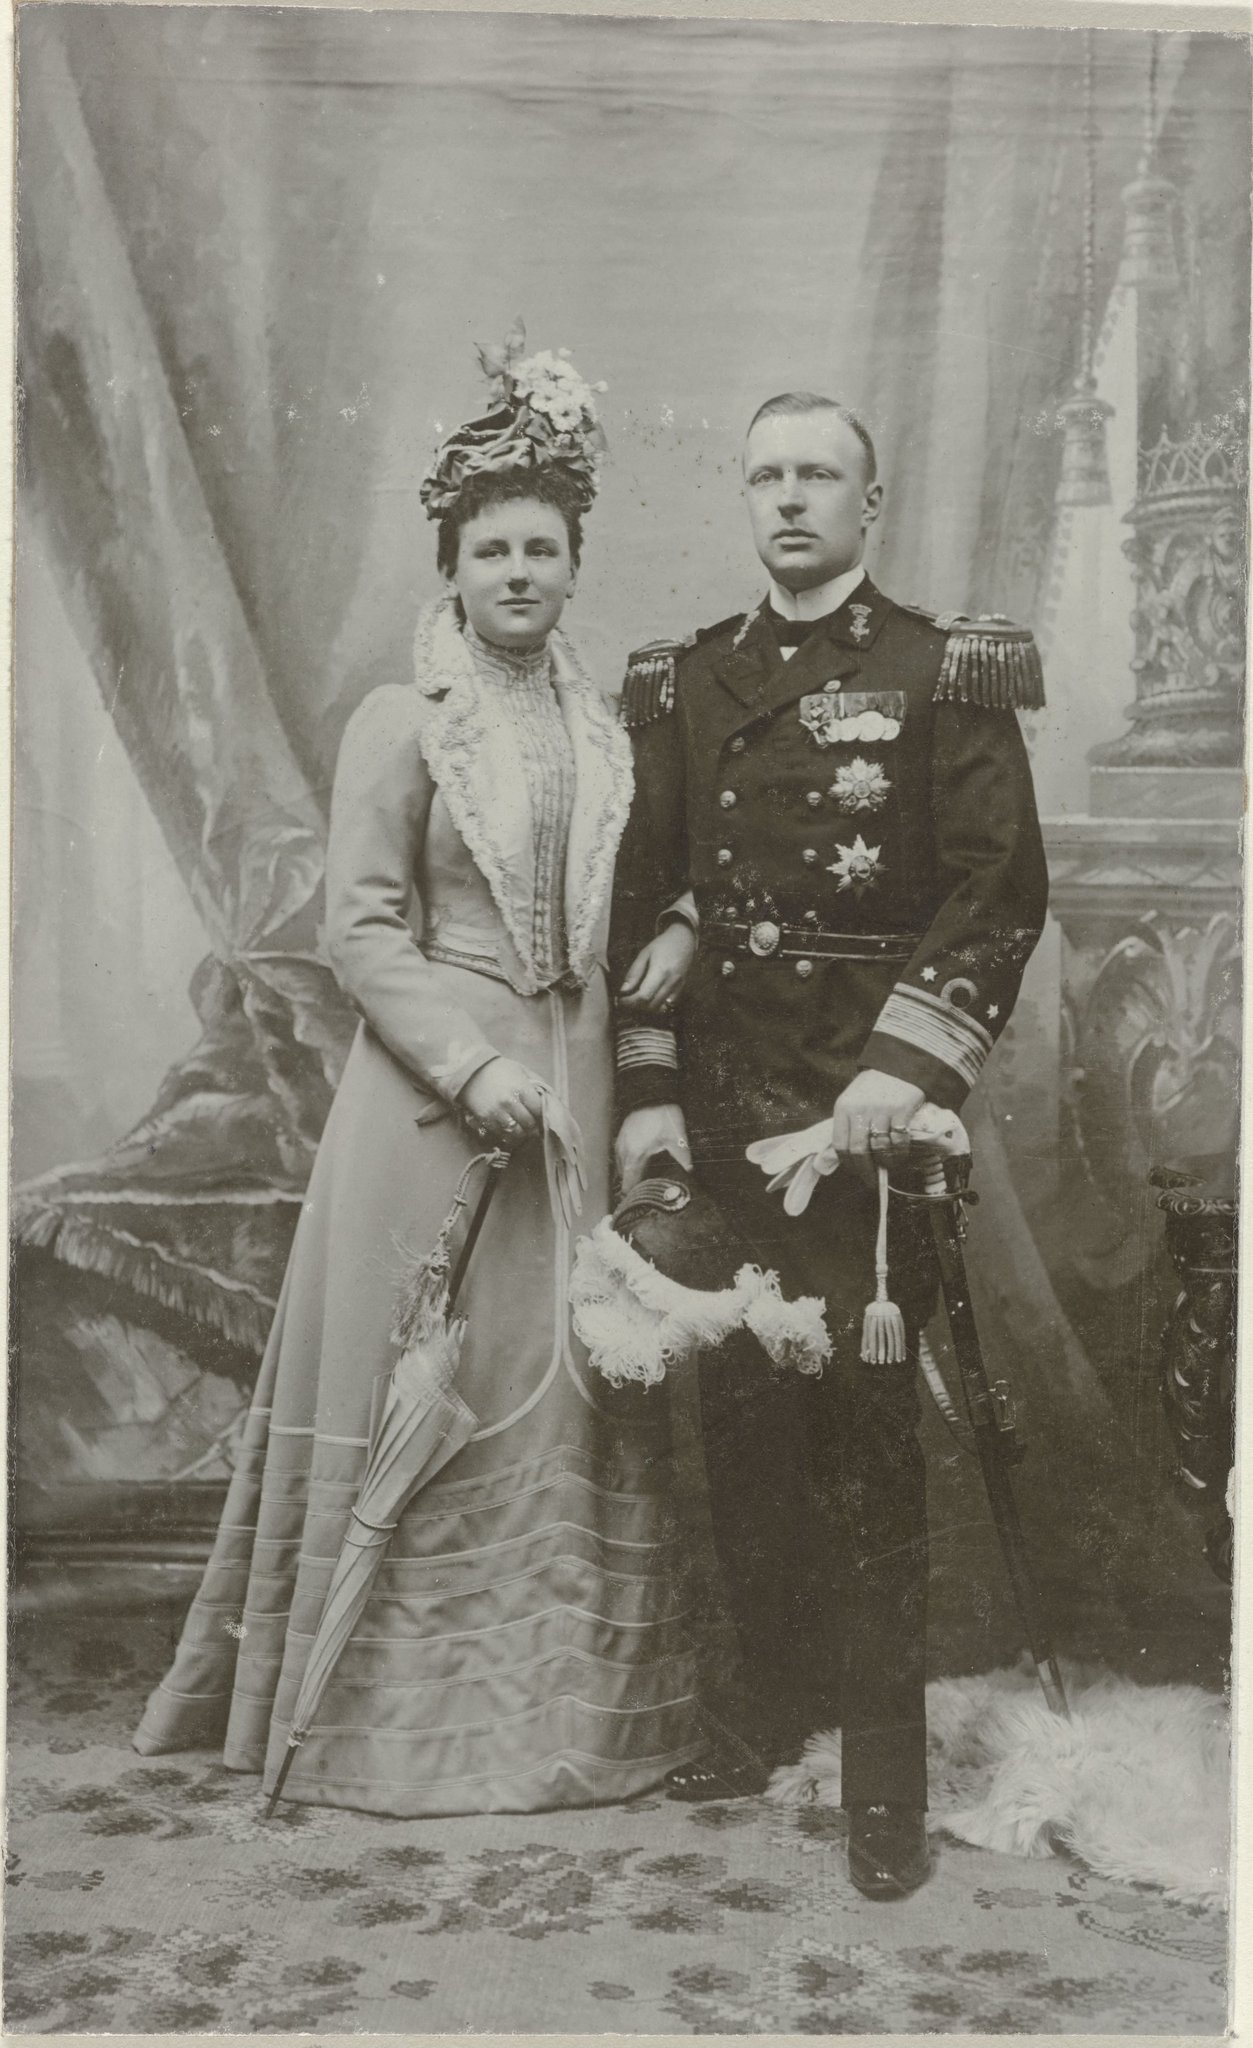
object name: photograph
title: Portret van Wilhelmina, koningin der Nederlanden, en Hendrik van Mecklenburg-Schwerin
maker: Anonymous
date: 1901-1910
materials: photographic support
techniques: photography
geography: netherlands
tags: print maker, wilhelmina of the netherlands, the hague, hendrik (prins der nederlanden (1876-1934))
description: De hier vermelde titel verwijst naar de hoogst verkregen titel van de geportretteerde, niet per se naar de titel die de geportretteerde op deze voorstelling draagt.